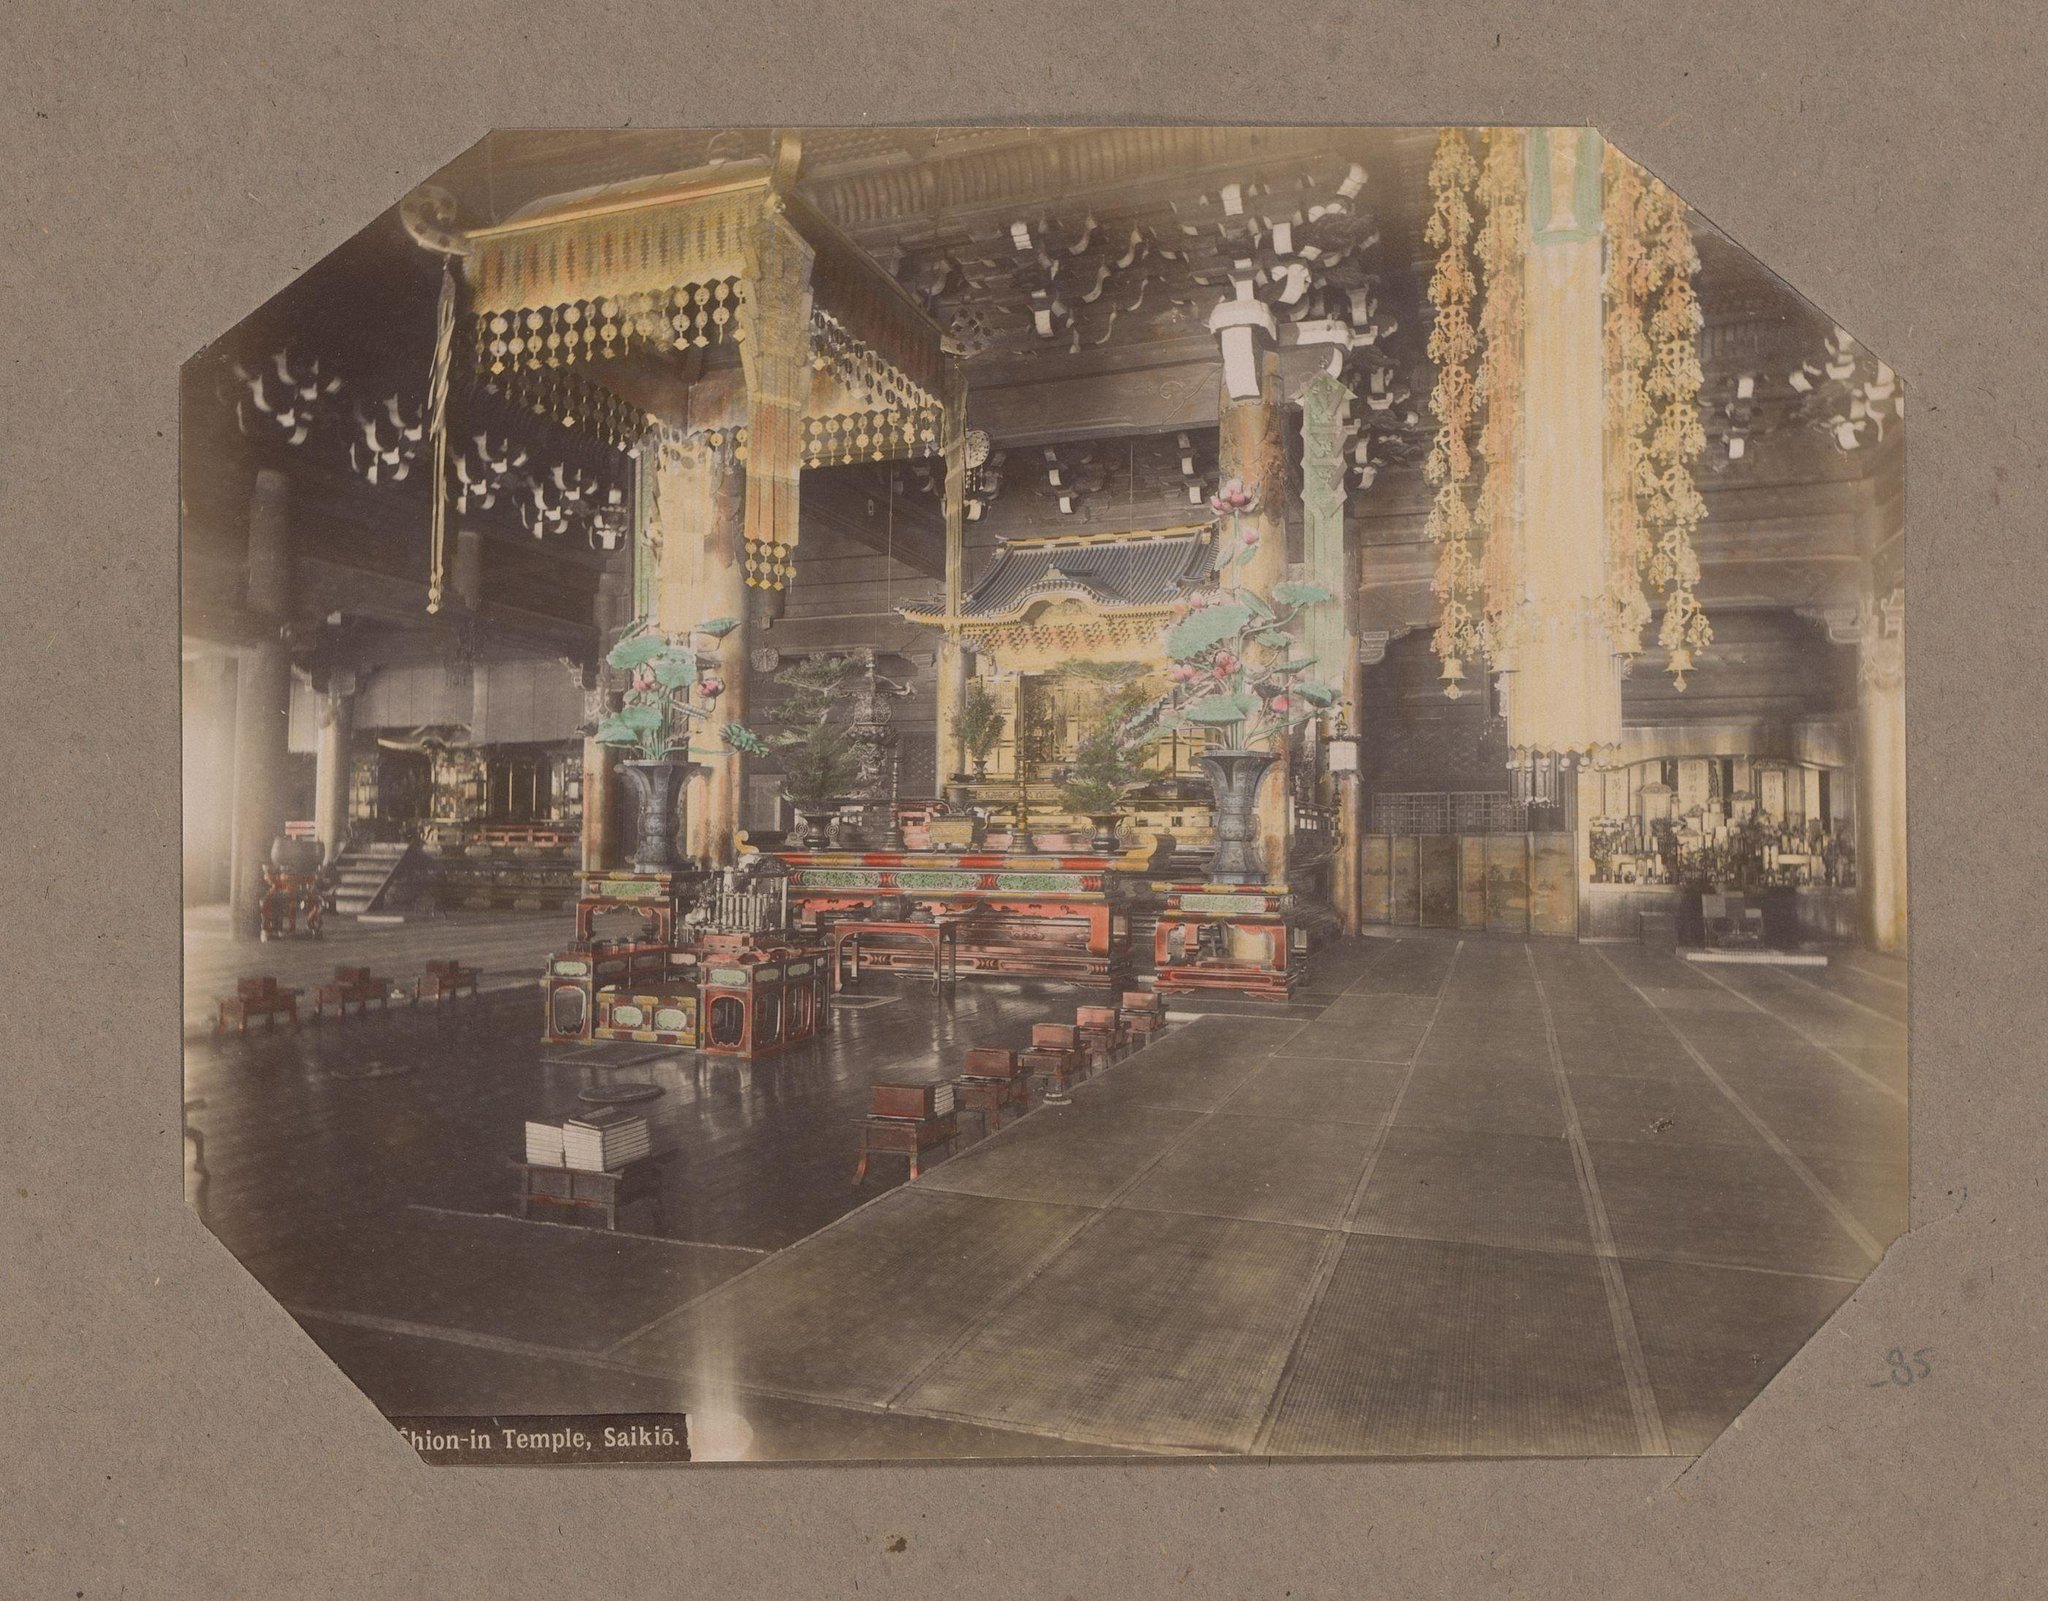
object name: album leaf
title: Interieur van de Chion-in tempel in Kyoto, Japan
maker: Anonymous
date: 1890-1903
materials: paper, photographic support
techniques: albumen print, hand coloring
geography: kyoto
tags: temple, shrine ~ hinduism, buddhism, jainism, interior of the house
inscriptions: inscription: ‘1166 Interior of Chion-in Temple, Saikio’